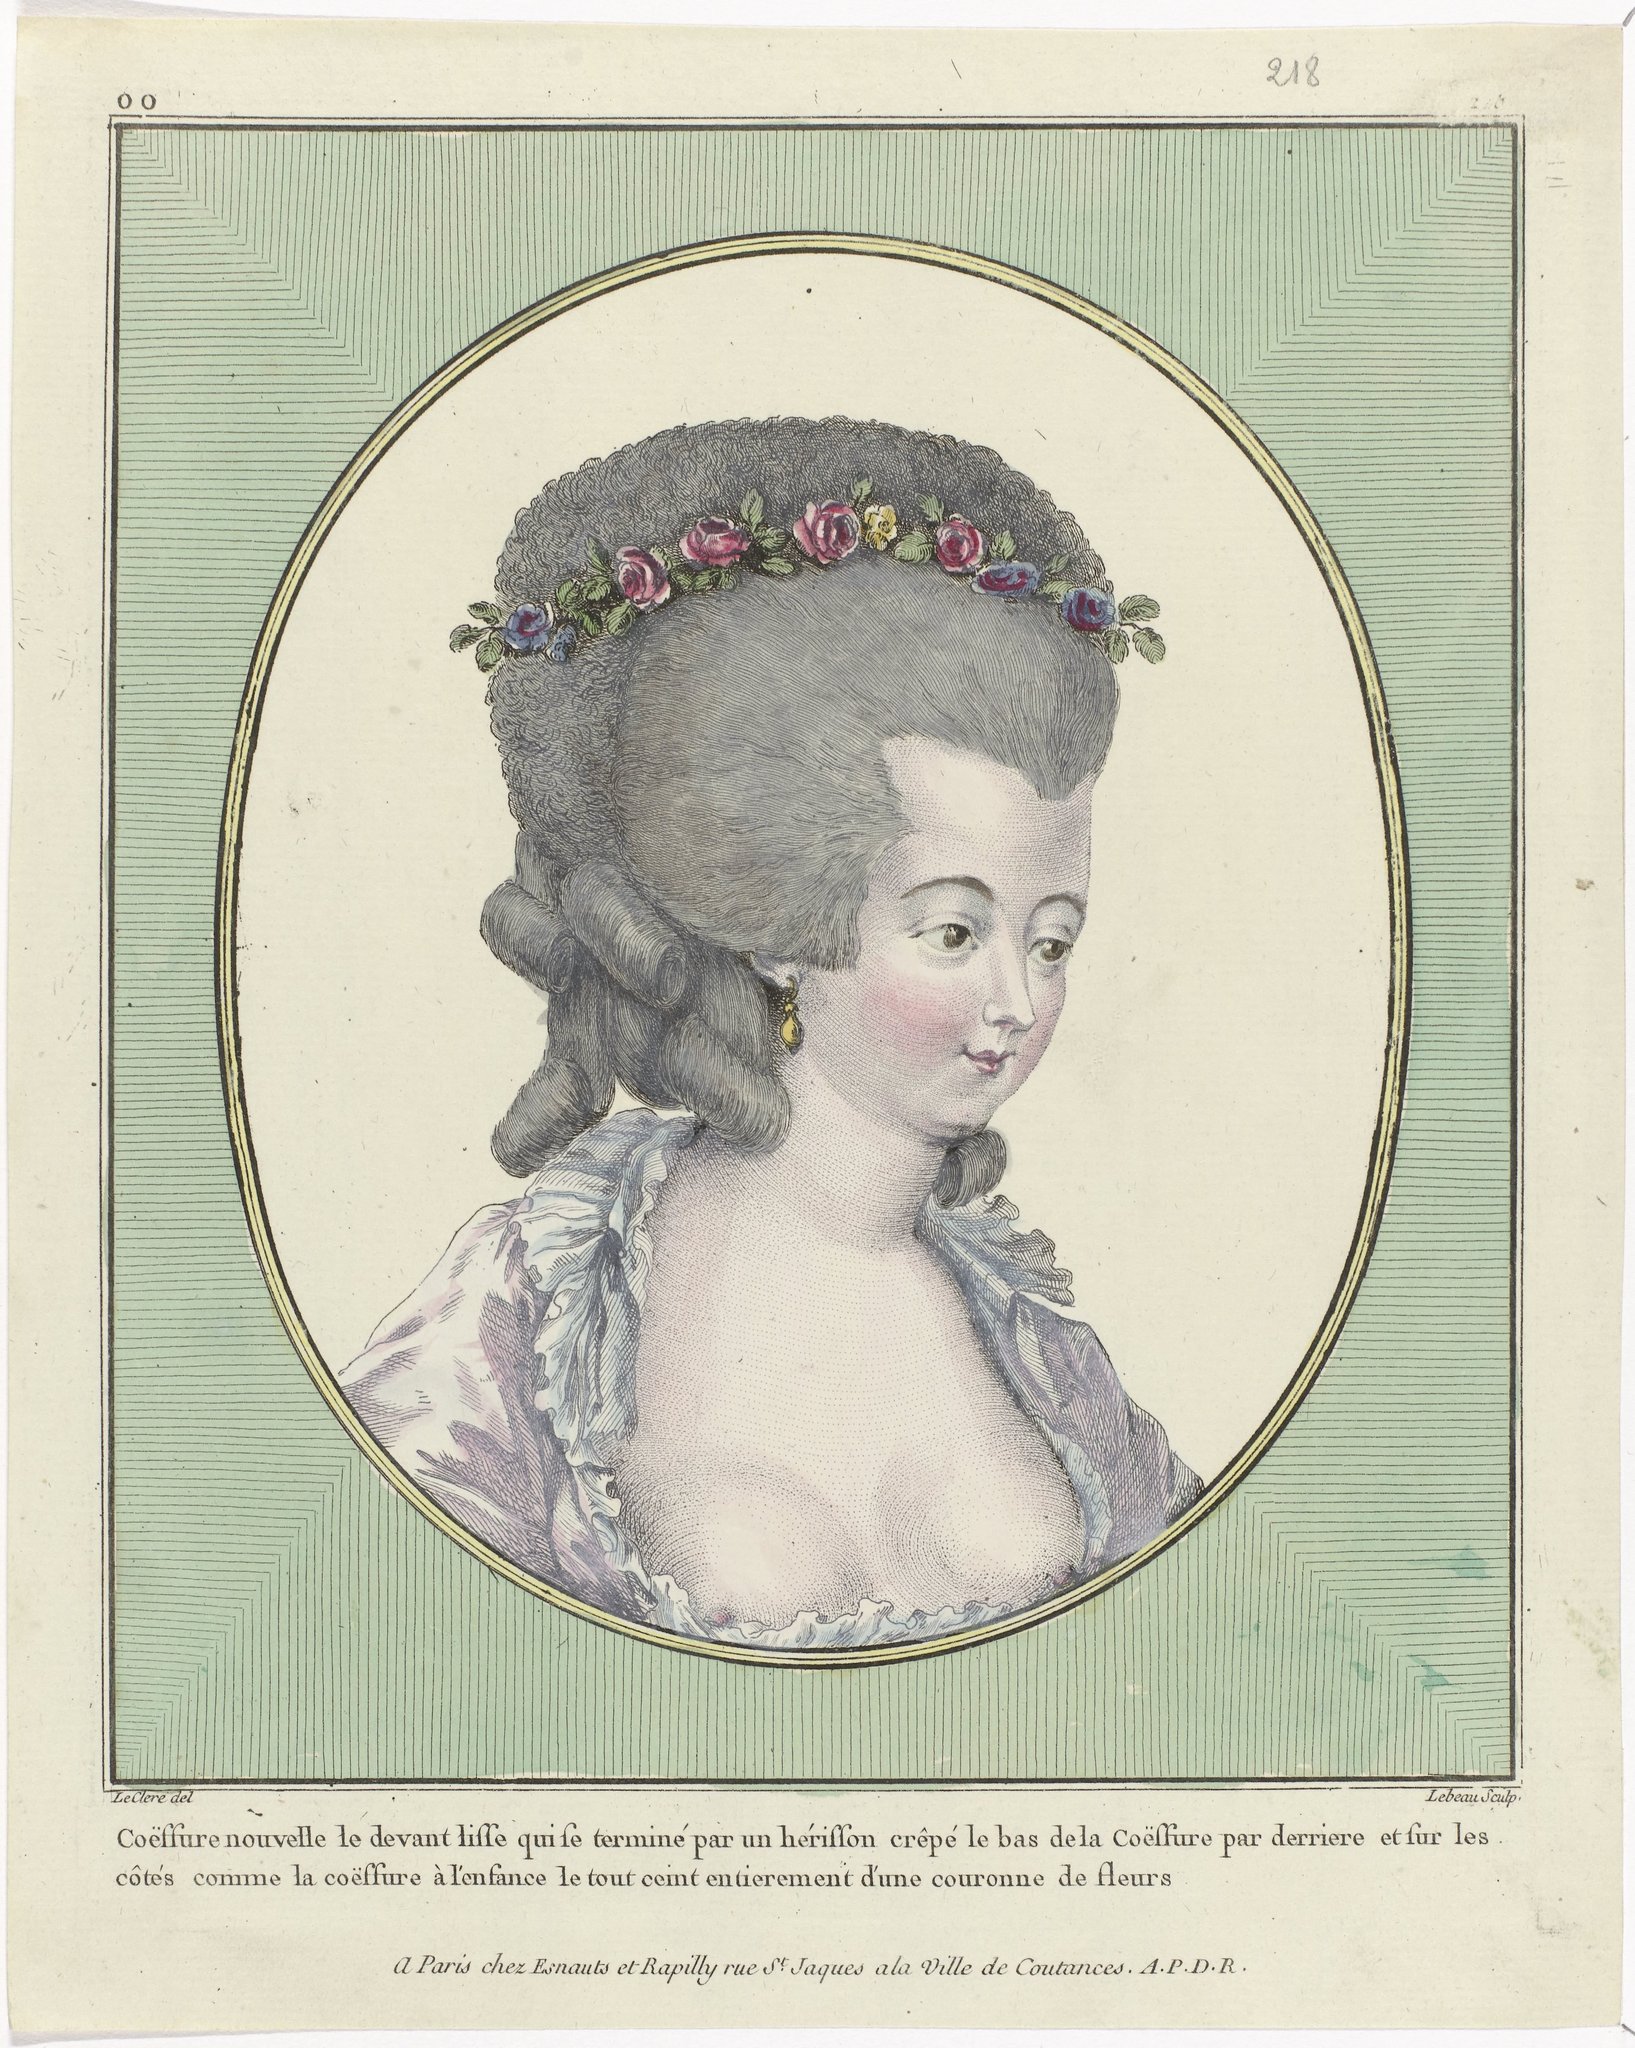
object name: fashion print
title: Coiffures, Poufs, Hats and Bonnets: Eleven Coiffures and Headdresses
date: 1781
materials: paper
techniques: engraving, hand coloring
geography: paris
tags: flowers, ear-rings (+ women's clothes), styles of hairdress (herisson) - aa - ~ women, fashion plates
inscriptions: address: ‘A Paris chez Esnauts et Rapilly rue St. Jacques a la Ville de Coutances. A.P.D.R.’, inscription: ‘Coëffure nouvelle le devant lisse qui se terminé par un hérisson crêpé le bas de la Coëffure par derriere et sur les côtés comme la coëffure à l'enfance le tout ceint entierement d'une couronne de fleurs.’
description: Ladies’ hairstyles were ingenious works of art, built around a core of cushions and horsehair. Hair was piled high in curls and twists (chignons) and adorned with feathers, ribbons, artificial flowers, tulle and jewels to create various fancifully named poufs. Because the hair was dressed using animal fat and powdered with wheat flour, these poufs attracted all manner of insects. Far from hygienic, they moreover did not last long. When they went out, ladies protected their hairdos with a voluminous ribbed hood called a calèche 1. Hairdressers of the time, who styled themselves as artists, used prints to advertise their latest creations and craftsmanship 2 3.